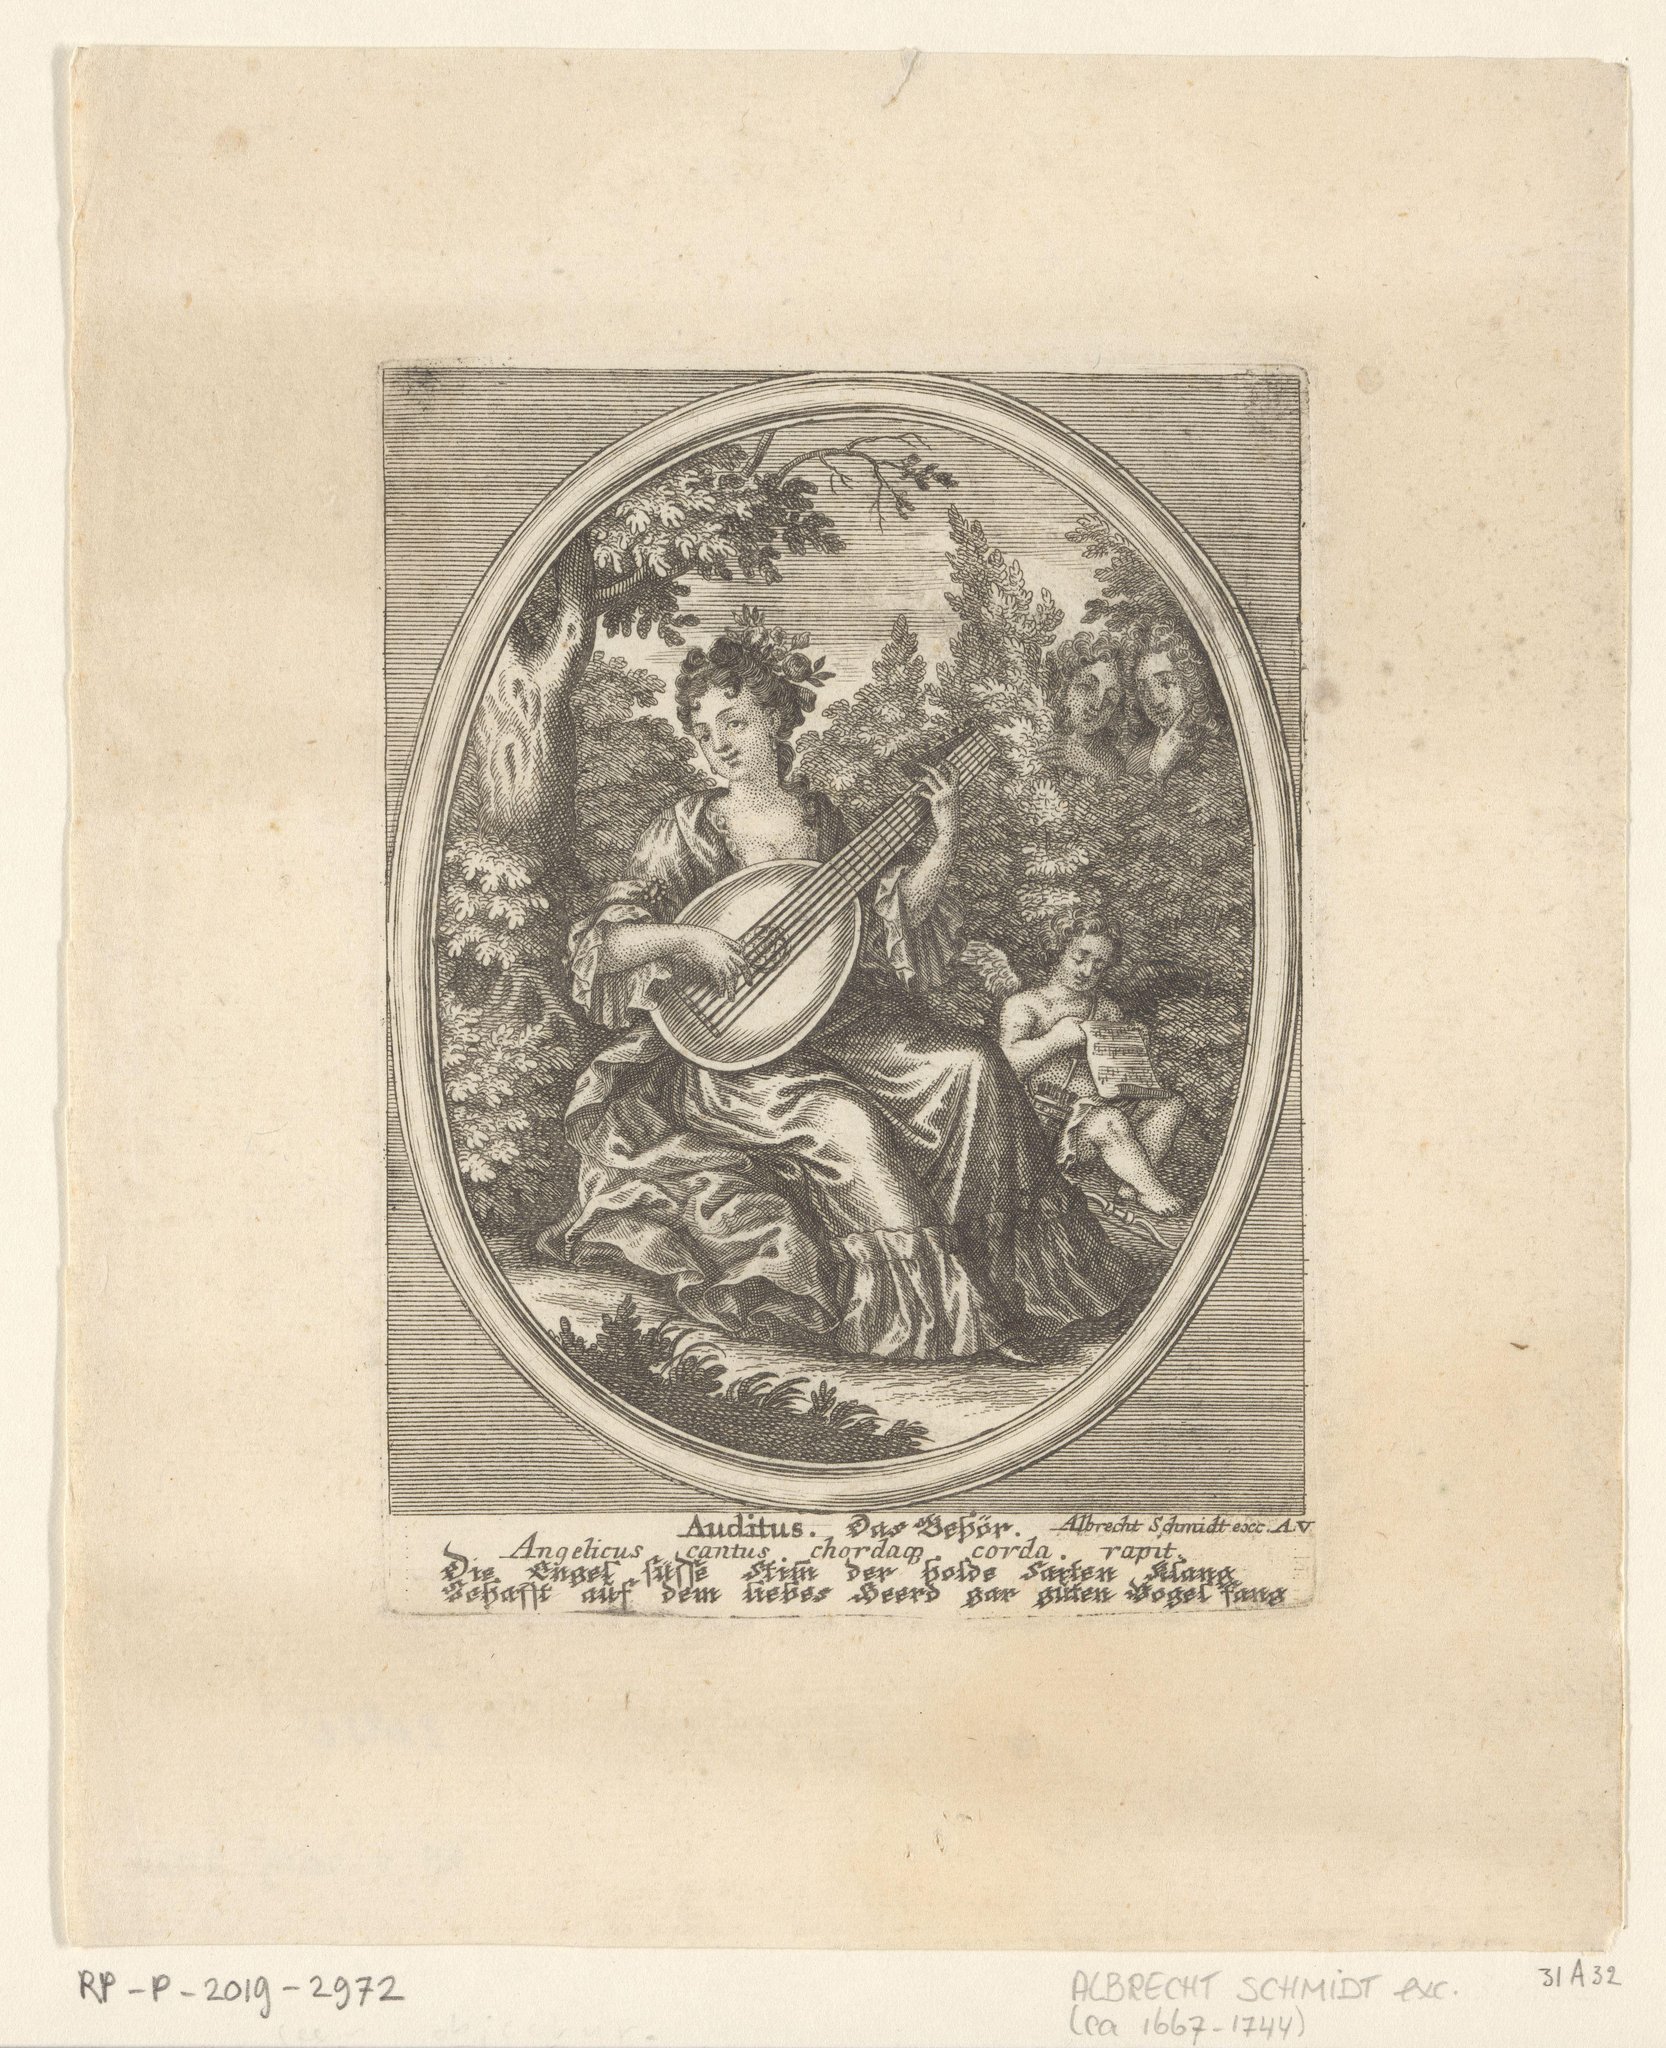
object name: print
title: Personificaties van de vijf zintuigen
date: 1677-1744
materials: paper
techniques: engraving, etching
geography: germany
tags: hearing, listening (one of the five senses)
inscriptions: collector's mark: Lugt 2228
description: Maakt waarschijnlijk deel uit van een serie met personificaties van de vijf zintuigen.